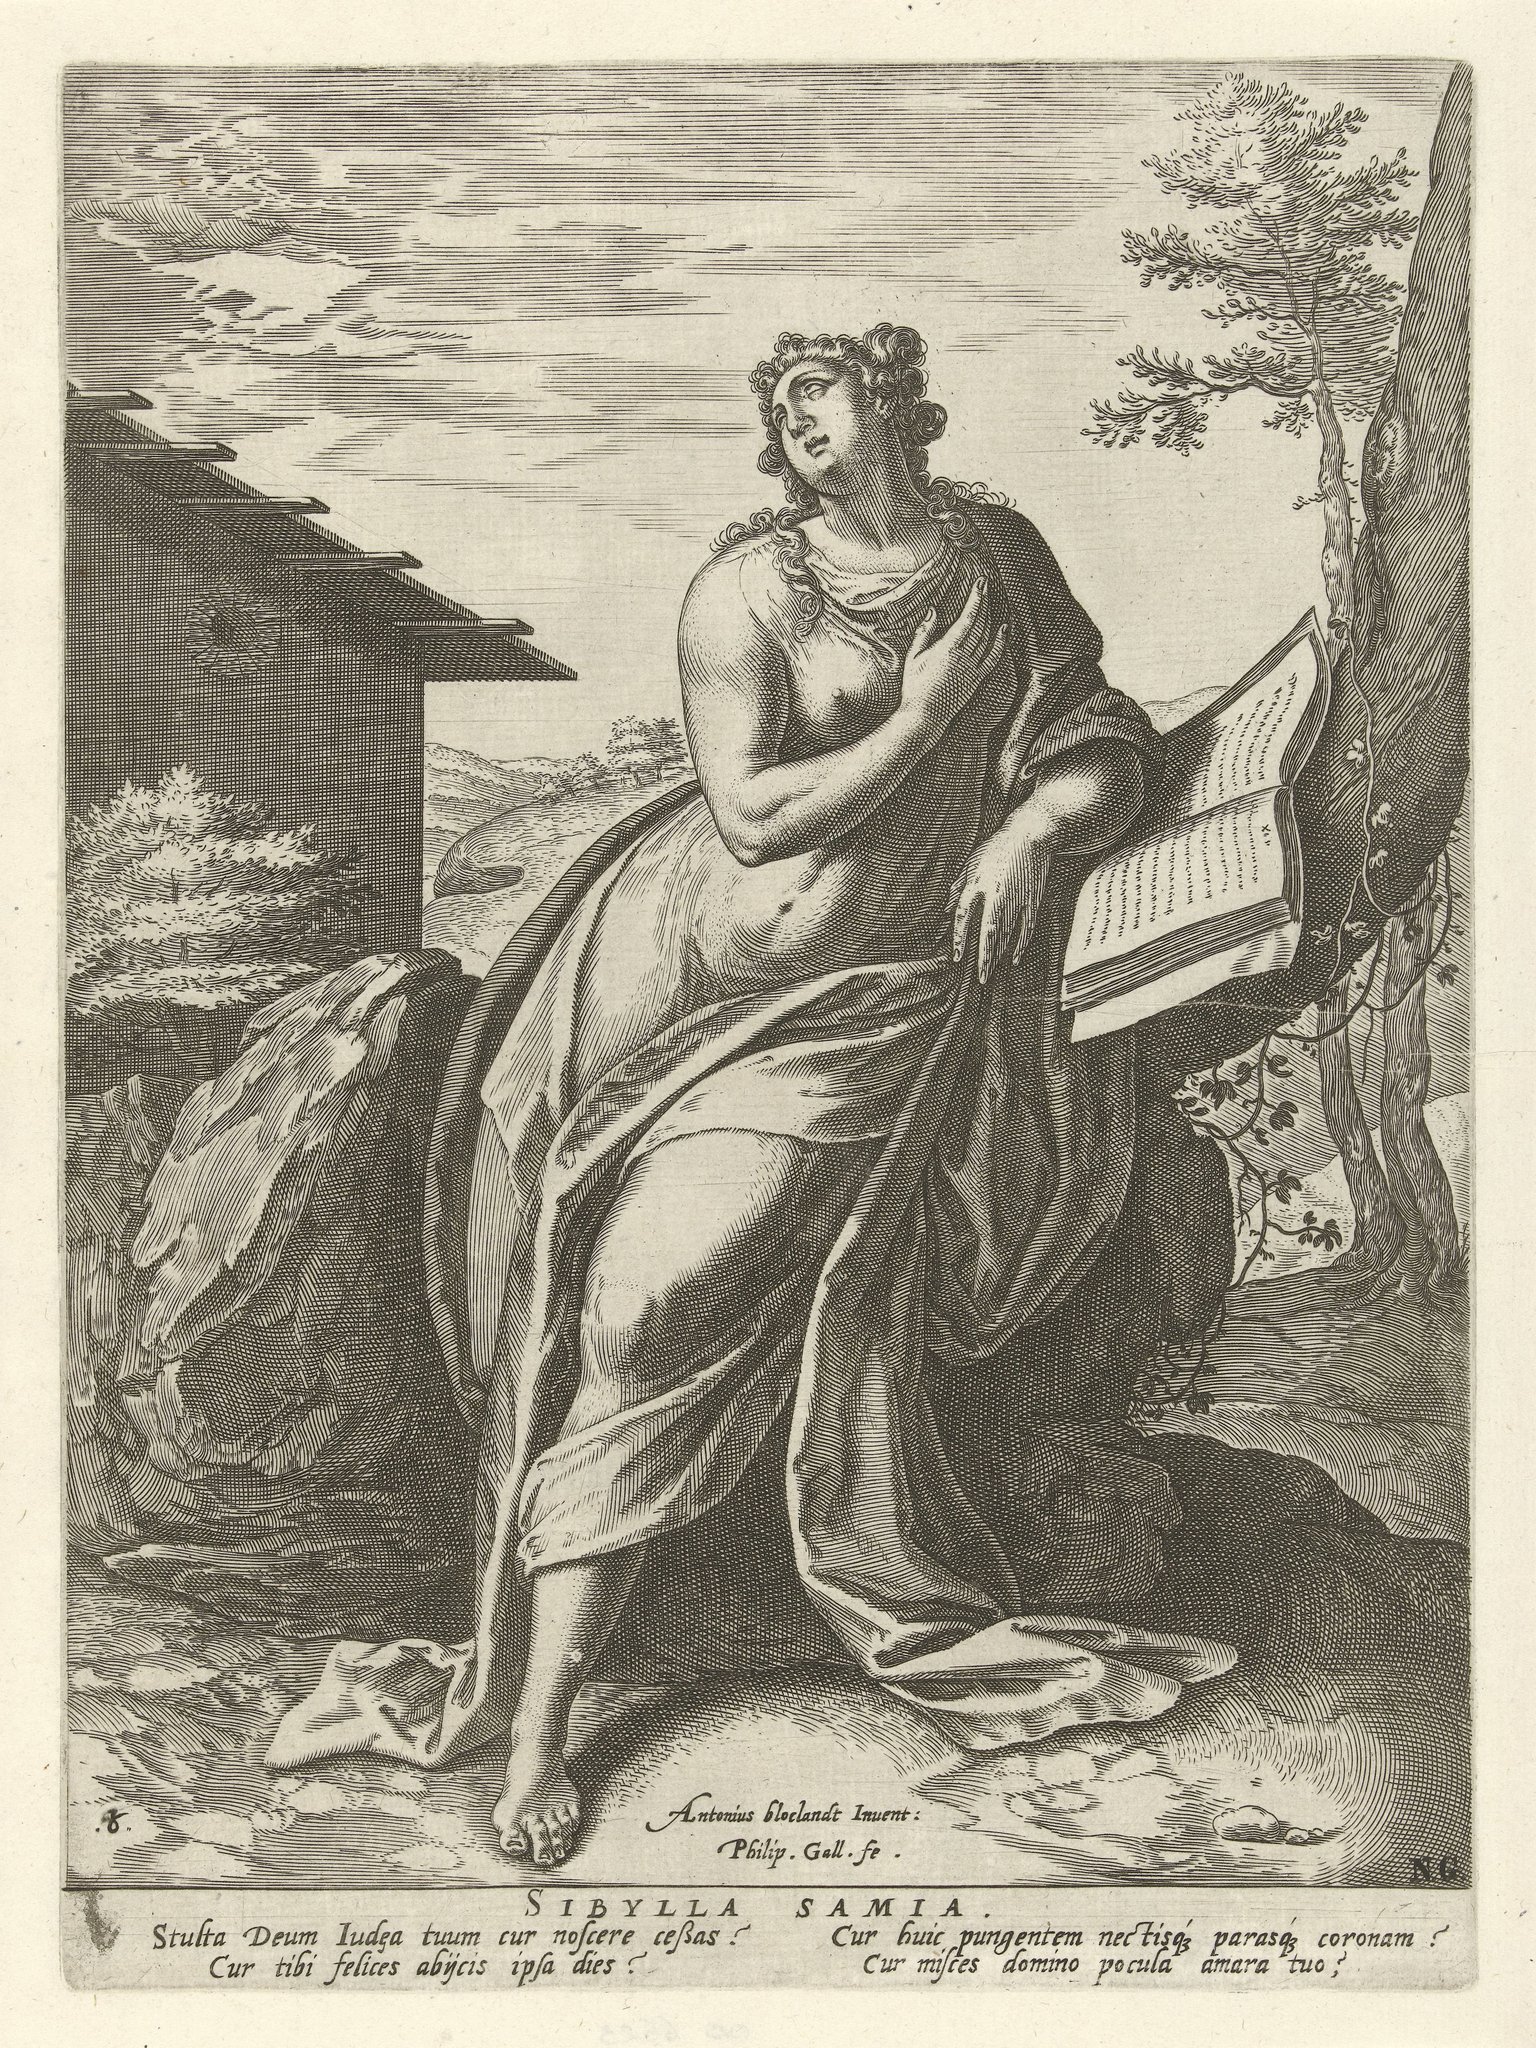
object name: print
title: Sibillen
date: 1575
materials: paper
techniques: engraving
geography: antwerp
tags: samian sibyl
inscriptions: collector's mark: Lugt 2228, collector's mark: Lugt 1967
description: De Sibille van Samos zit op een rots. Een boek ligt opengeslagen naast haar. De prent heeft een Latijns onderschrift en maakt deel uit van een tiendelige serie over de Sibillen.